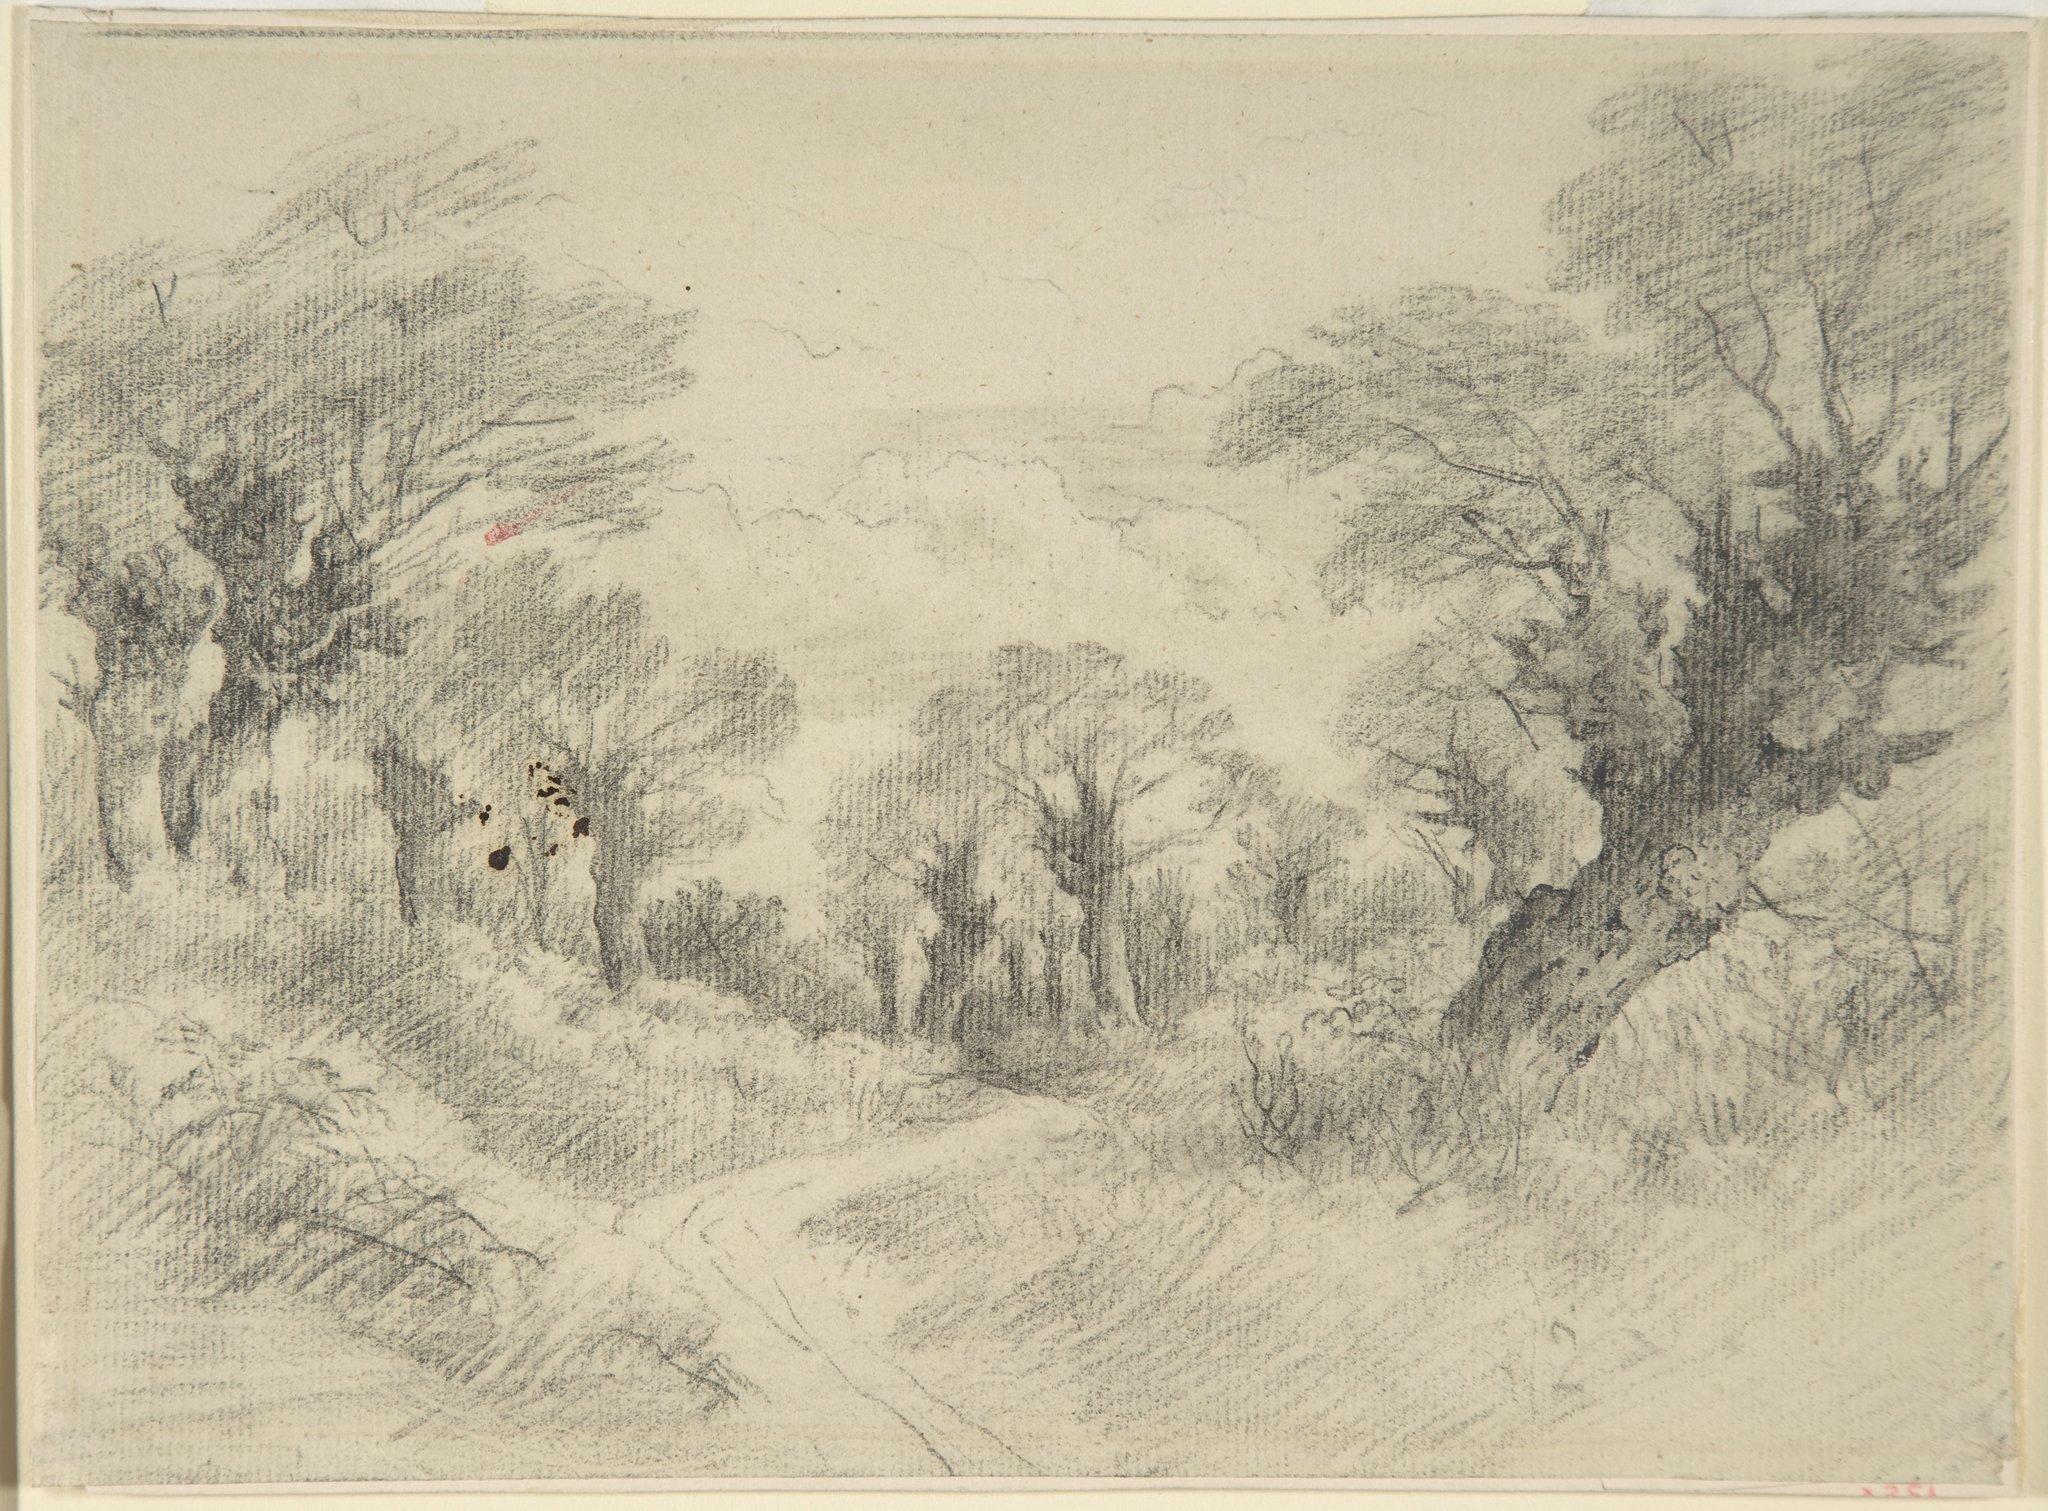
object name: drawing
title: Young pollards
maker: john constable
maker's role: artist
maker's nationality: british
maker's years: 1776-1837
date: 1801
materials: chalk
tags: trees